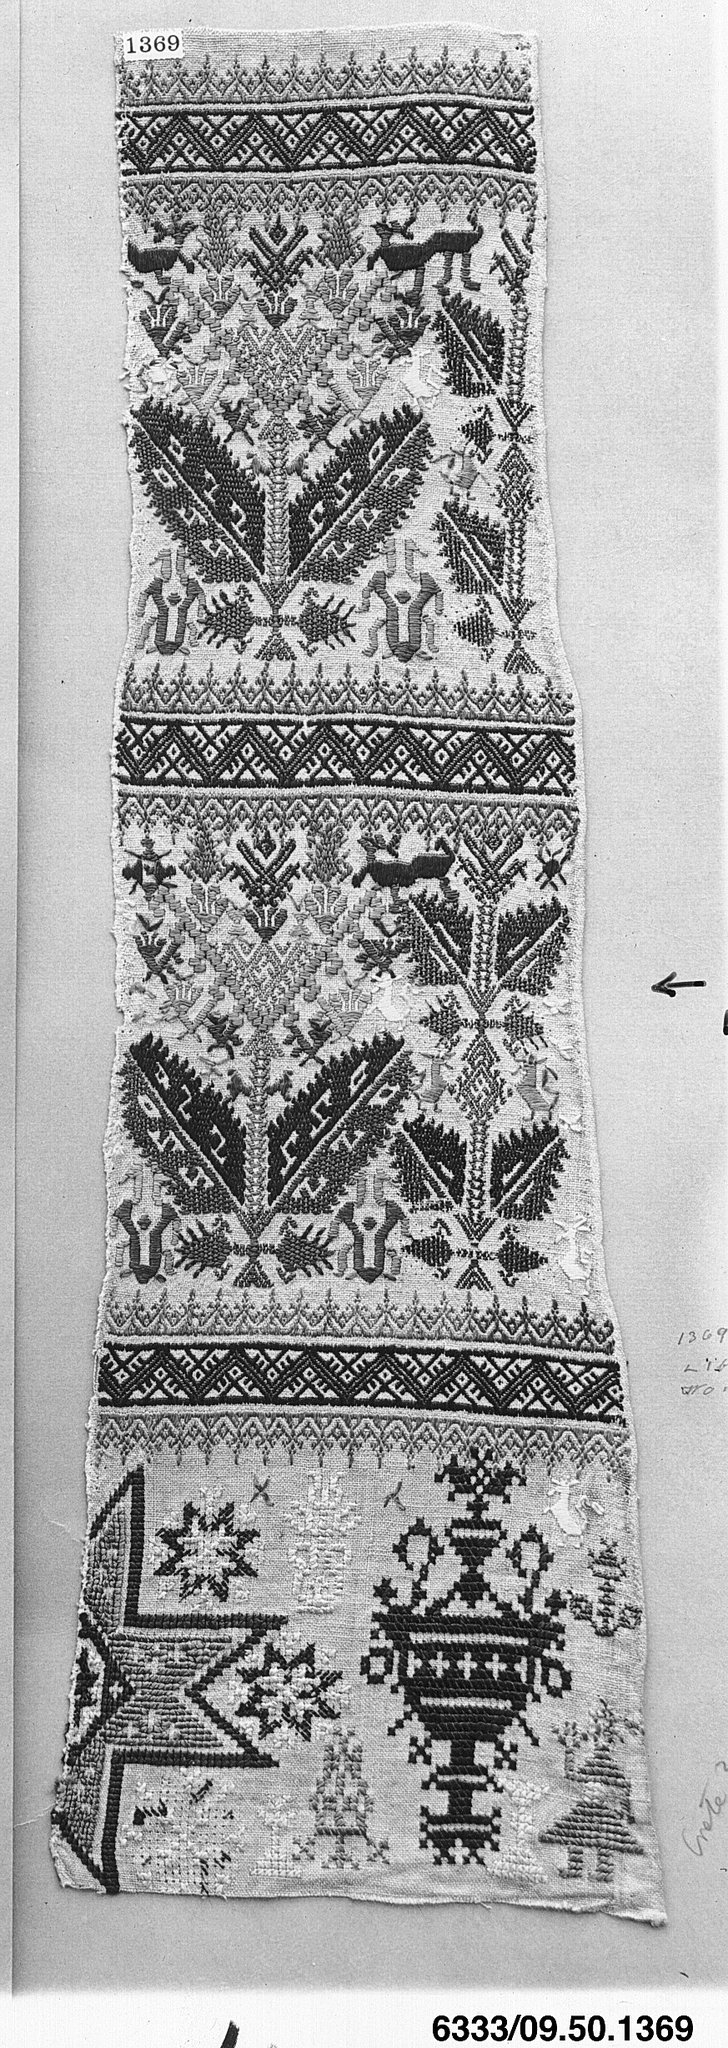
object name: bed tent door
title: Part of a door from a bed tent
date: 1701-1800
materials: linen, silk